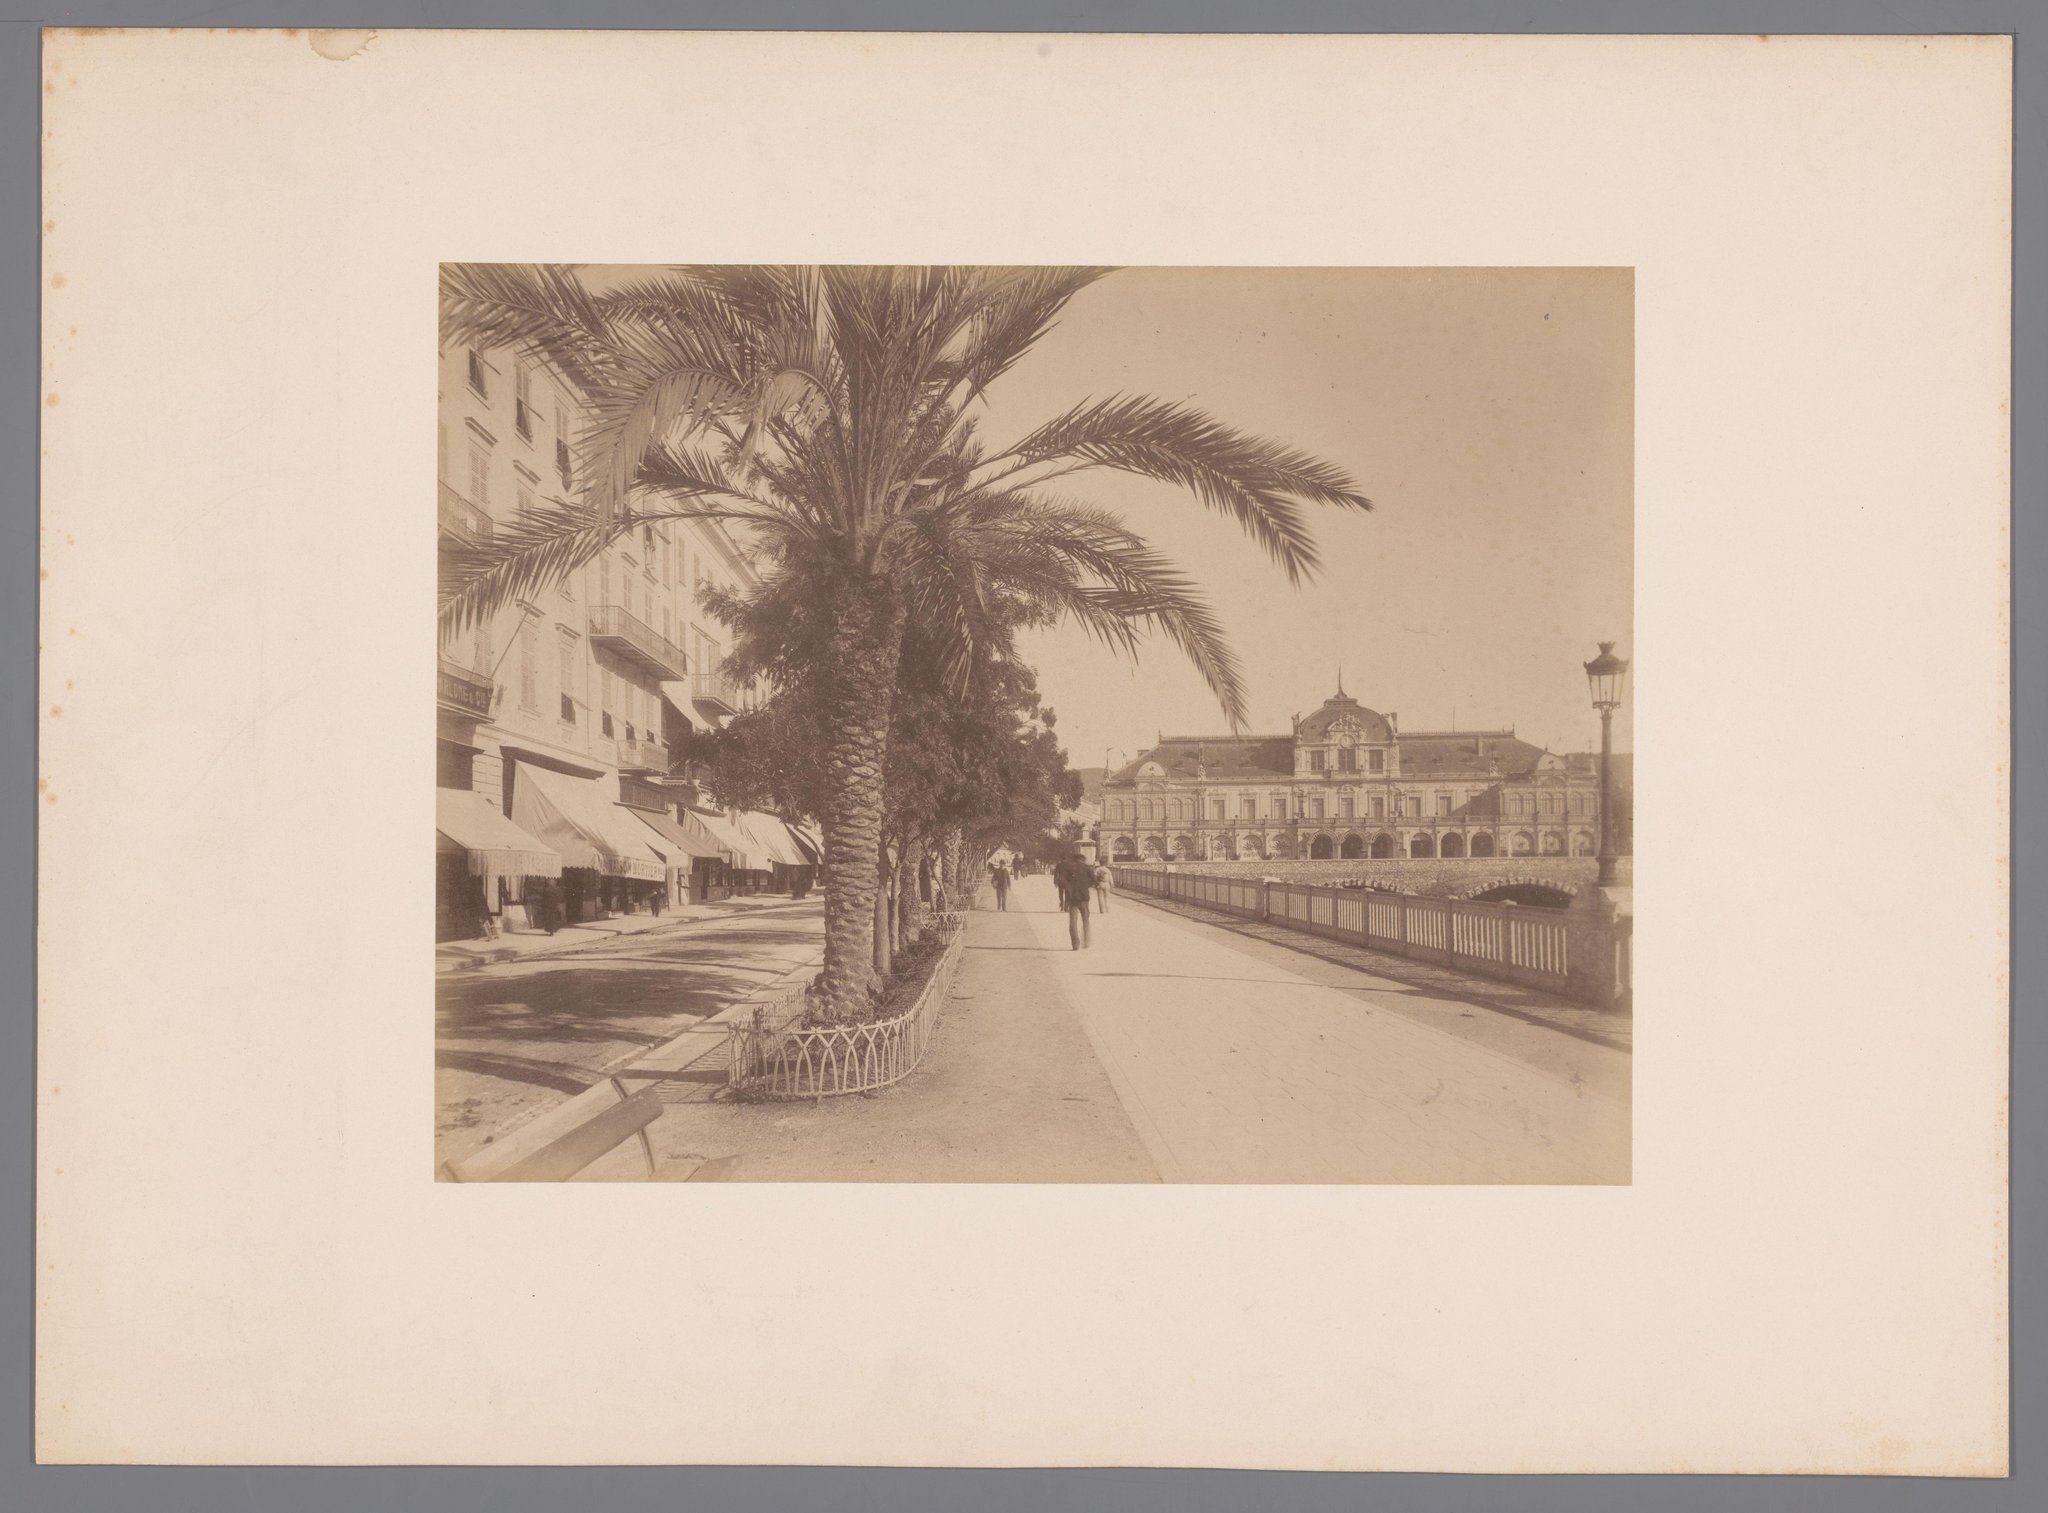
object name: photograph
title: Boulevard, Frankrijk [?]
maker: Anonymous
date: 1880-1910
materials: cardboard, photographic support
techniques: albumen print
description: Aanzicht op de boulevard met winkels links, een brug en daarachter een groot gebouw aan de rechterkant, met puien waarop 'Renaissance' staat [=museum?], en palm/andere bomen.